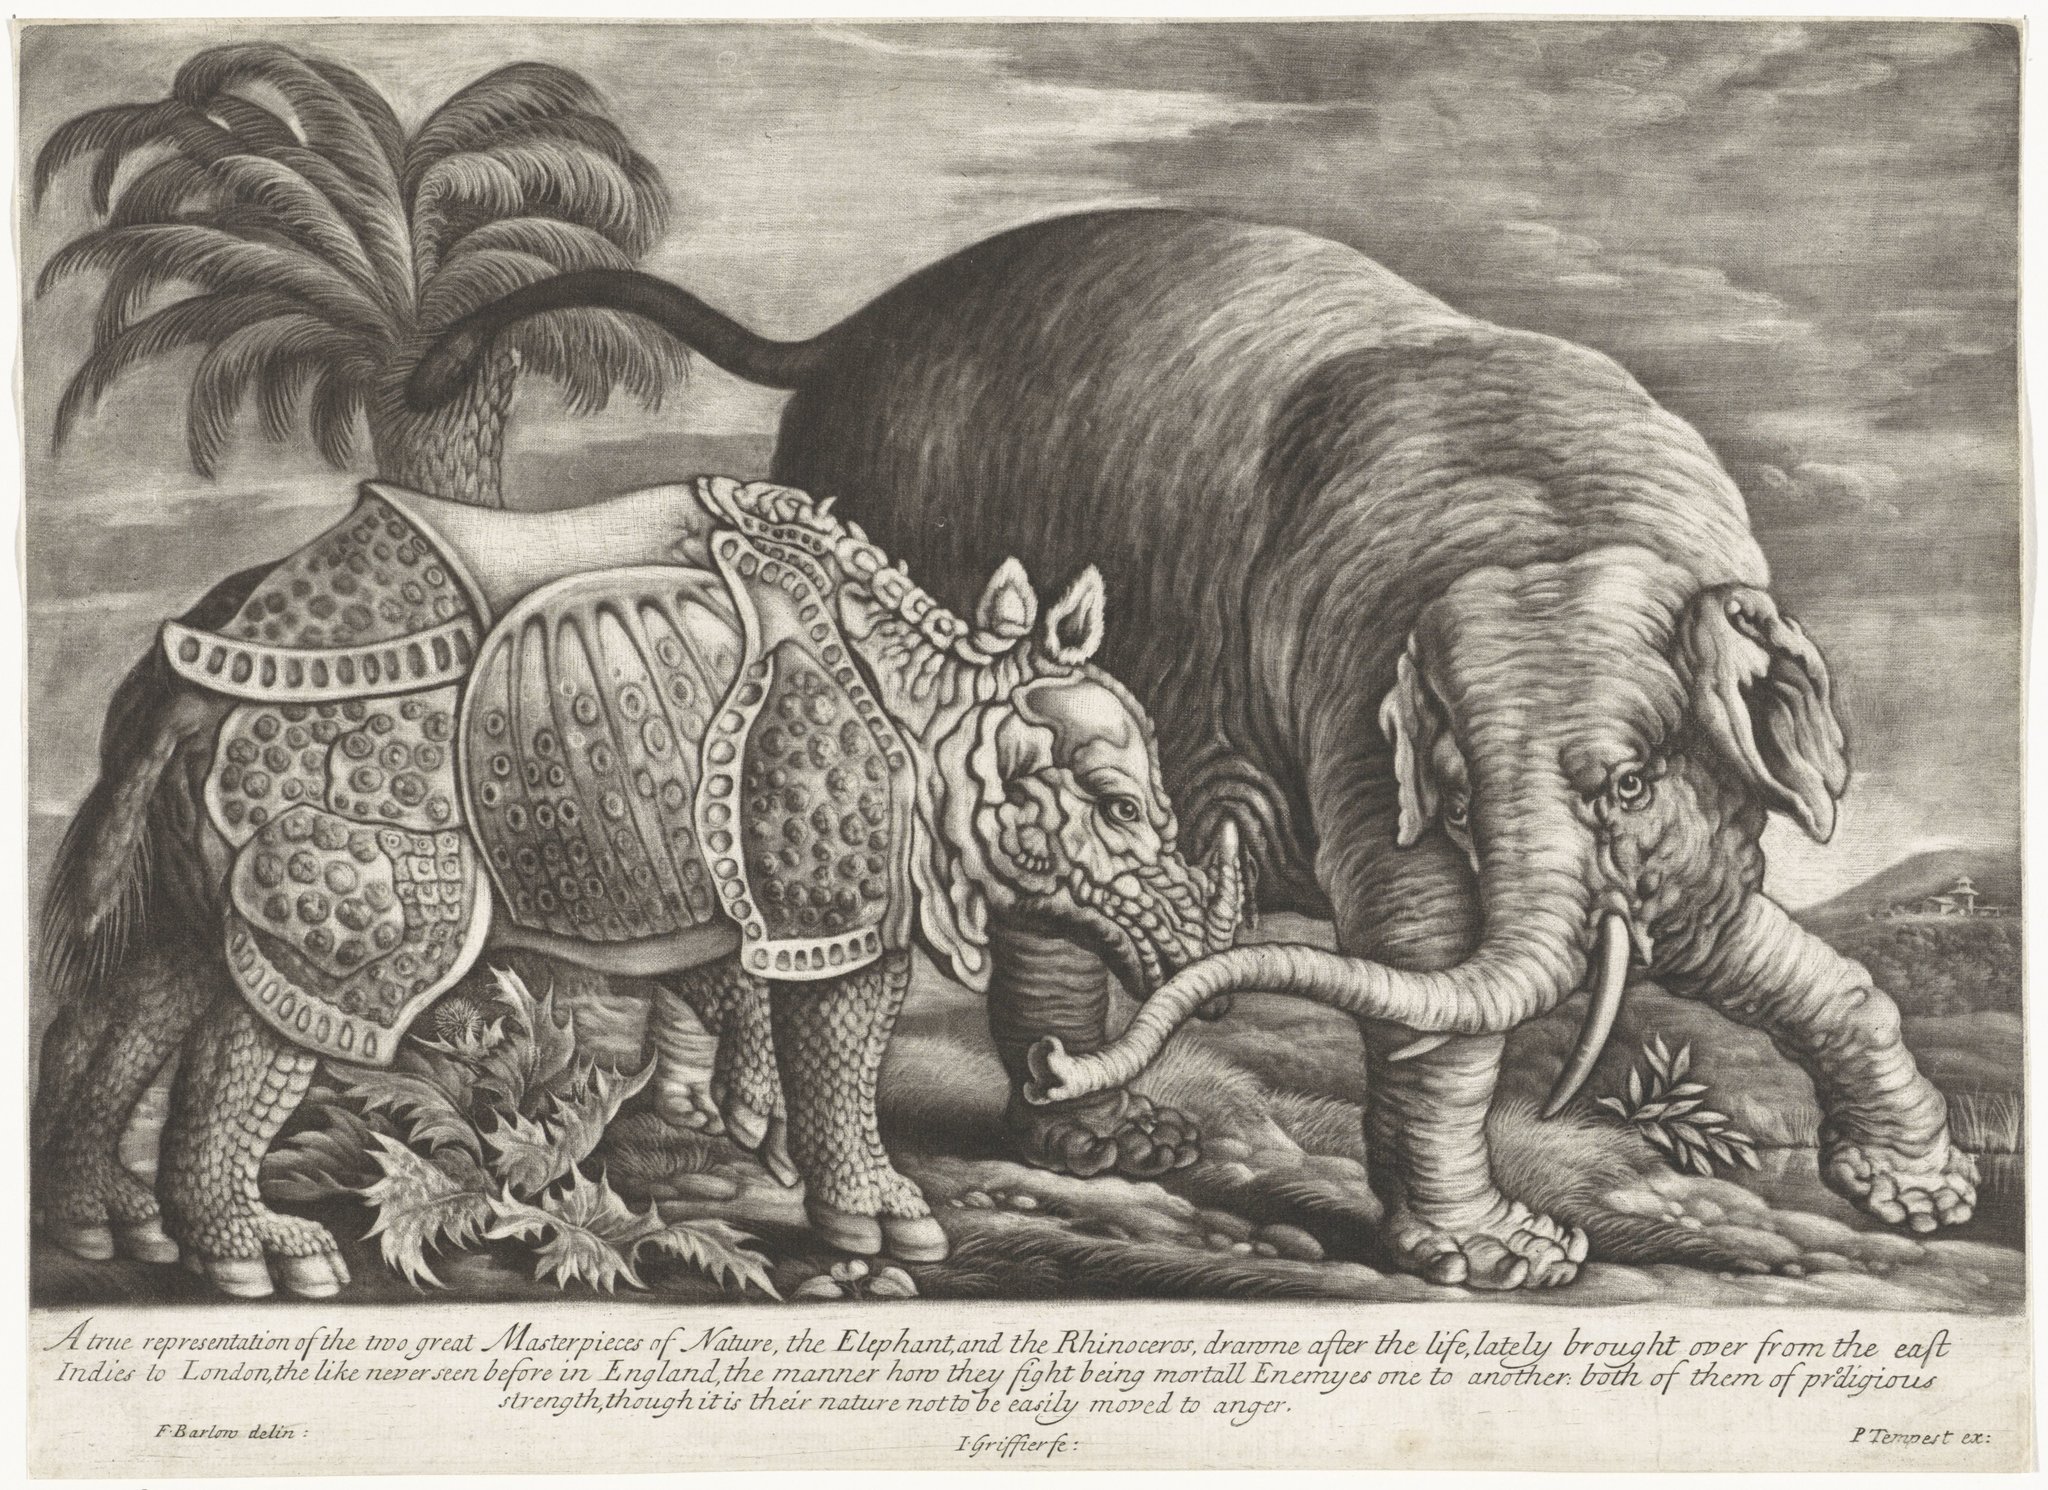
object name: print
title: Olifant en neushoorn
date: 1667-1717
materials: paper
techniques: engraving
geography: london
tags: hoofed animals: rhinoceros, trunked animals: elephant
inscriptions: collector's mark: Lugt 2228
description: In een landschap met een palm en distels staan een olifant en een neushoorn.